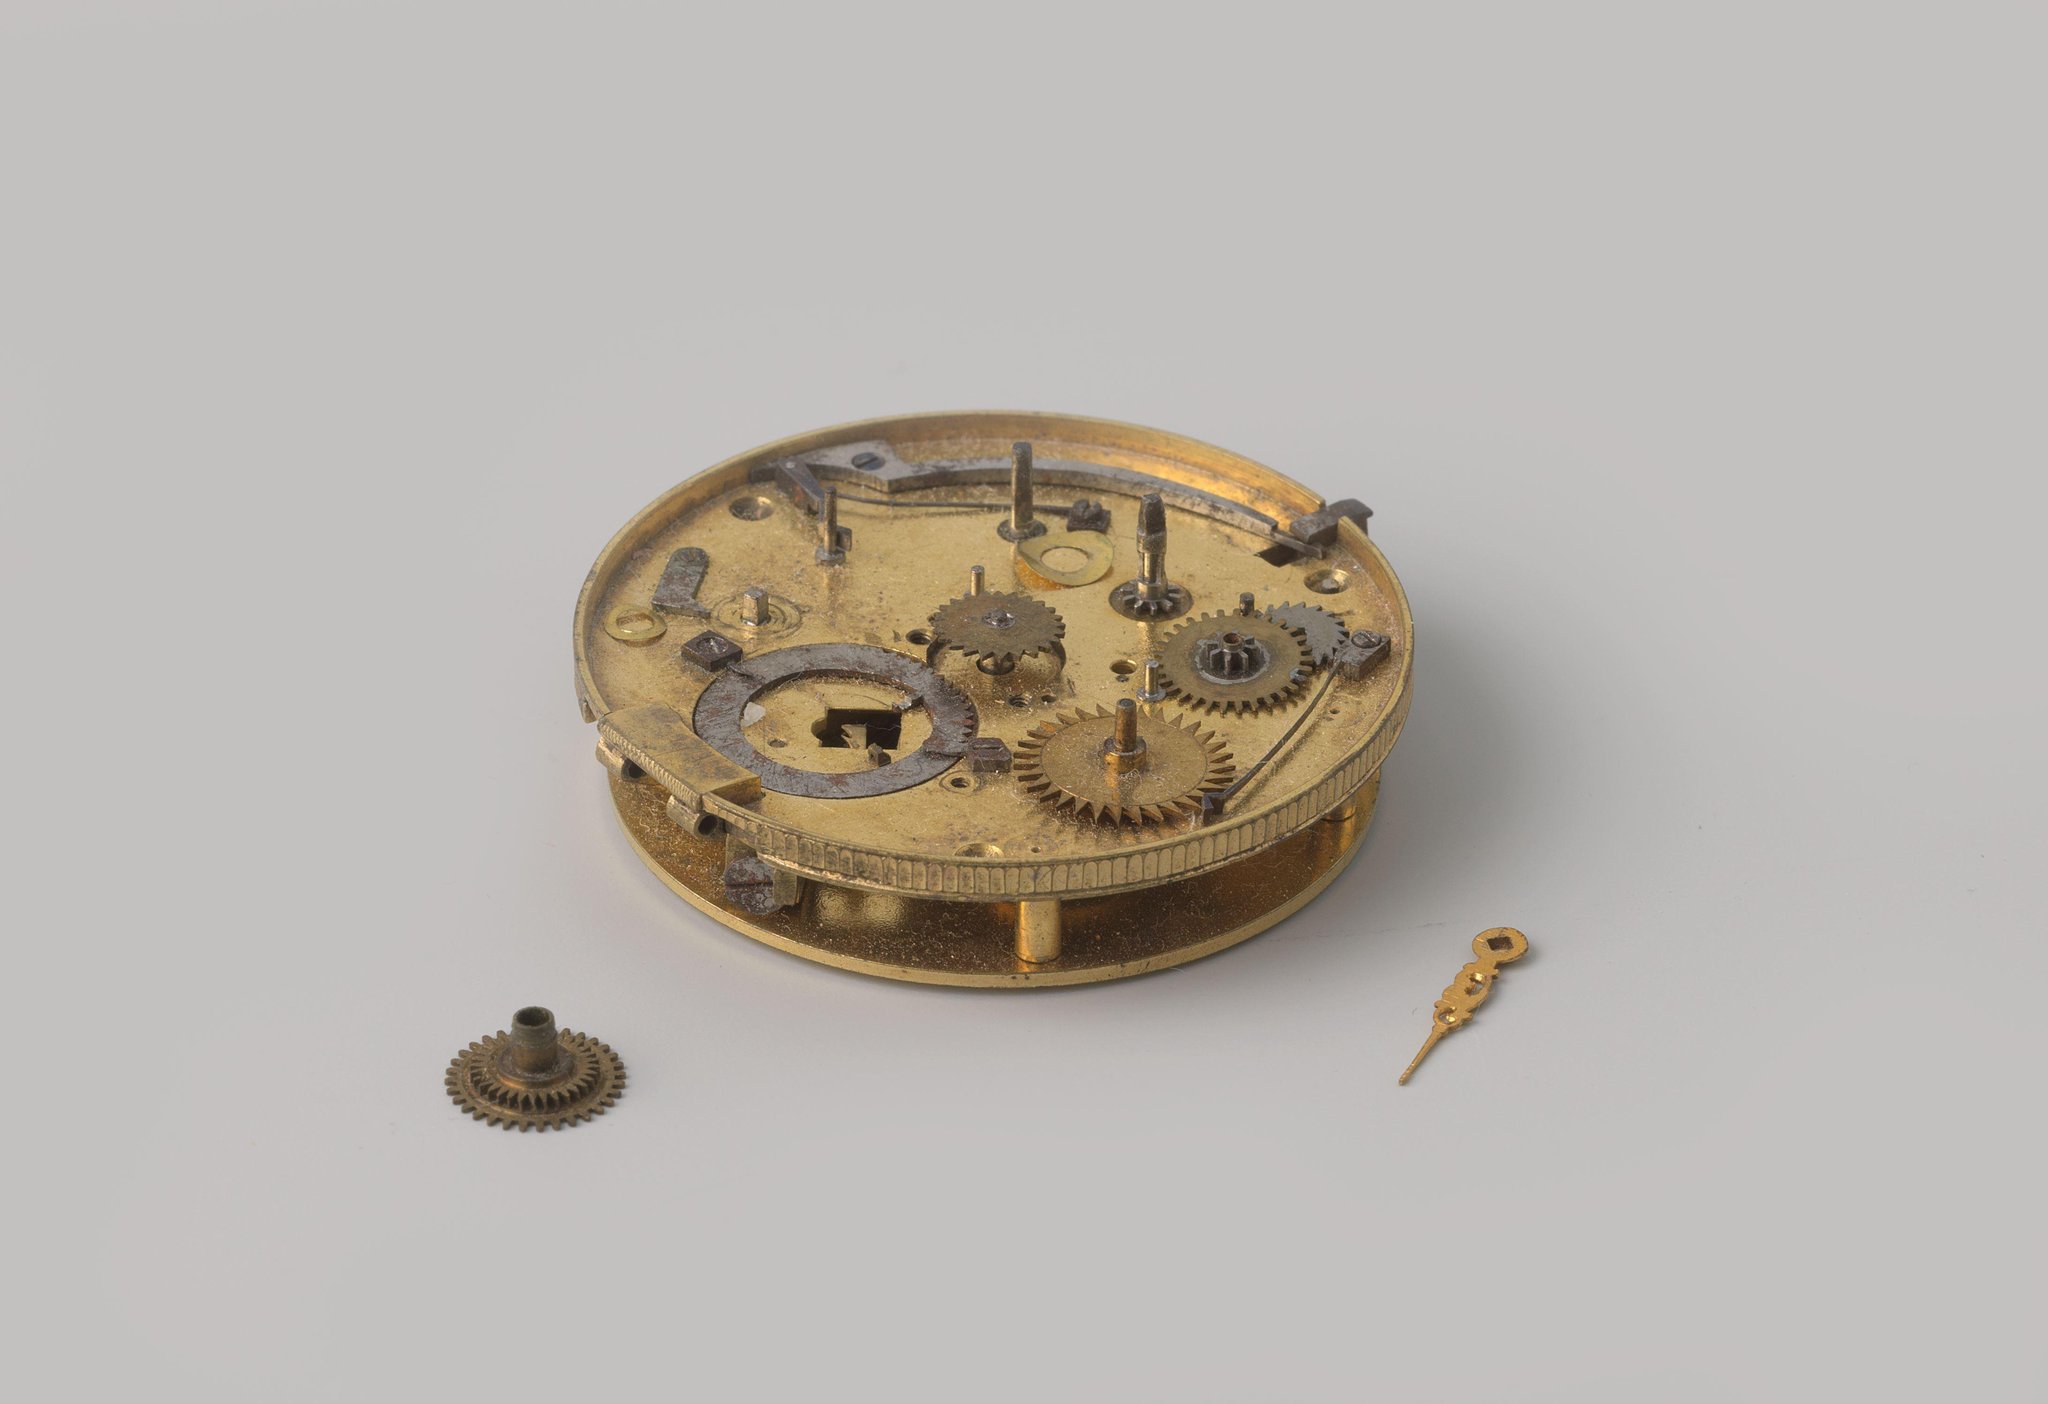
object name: clockwork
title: Uurwerk van herenhorloge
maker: Anonymous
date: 1850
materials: silver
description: Uurwerk van herenhorloge met zeven losse, kleine onderdelen.